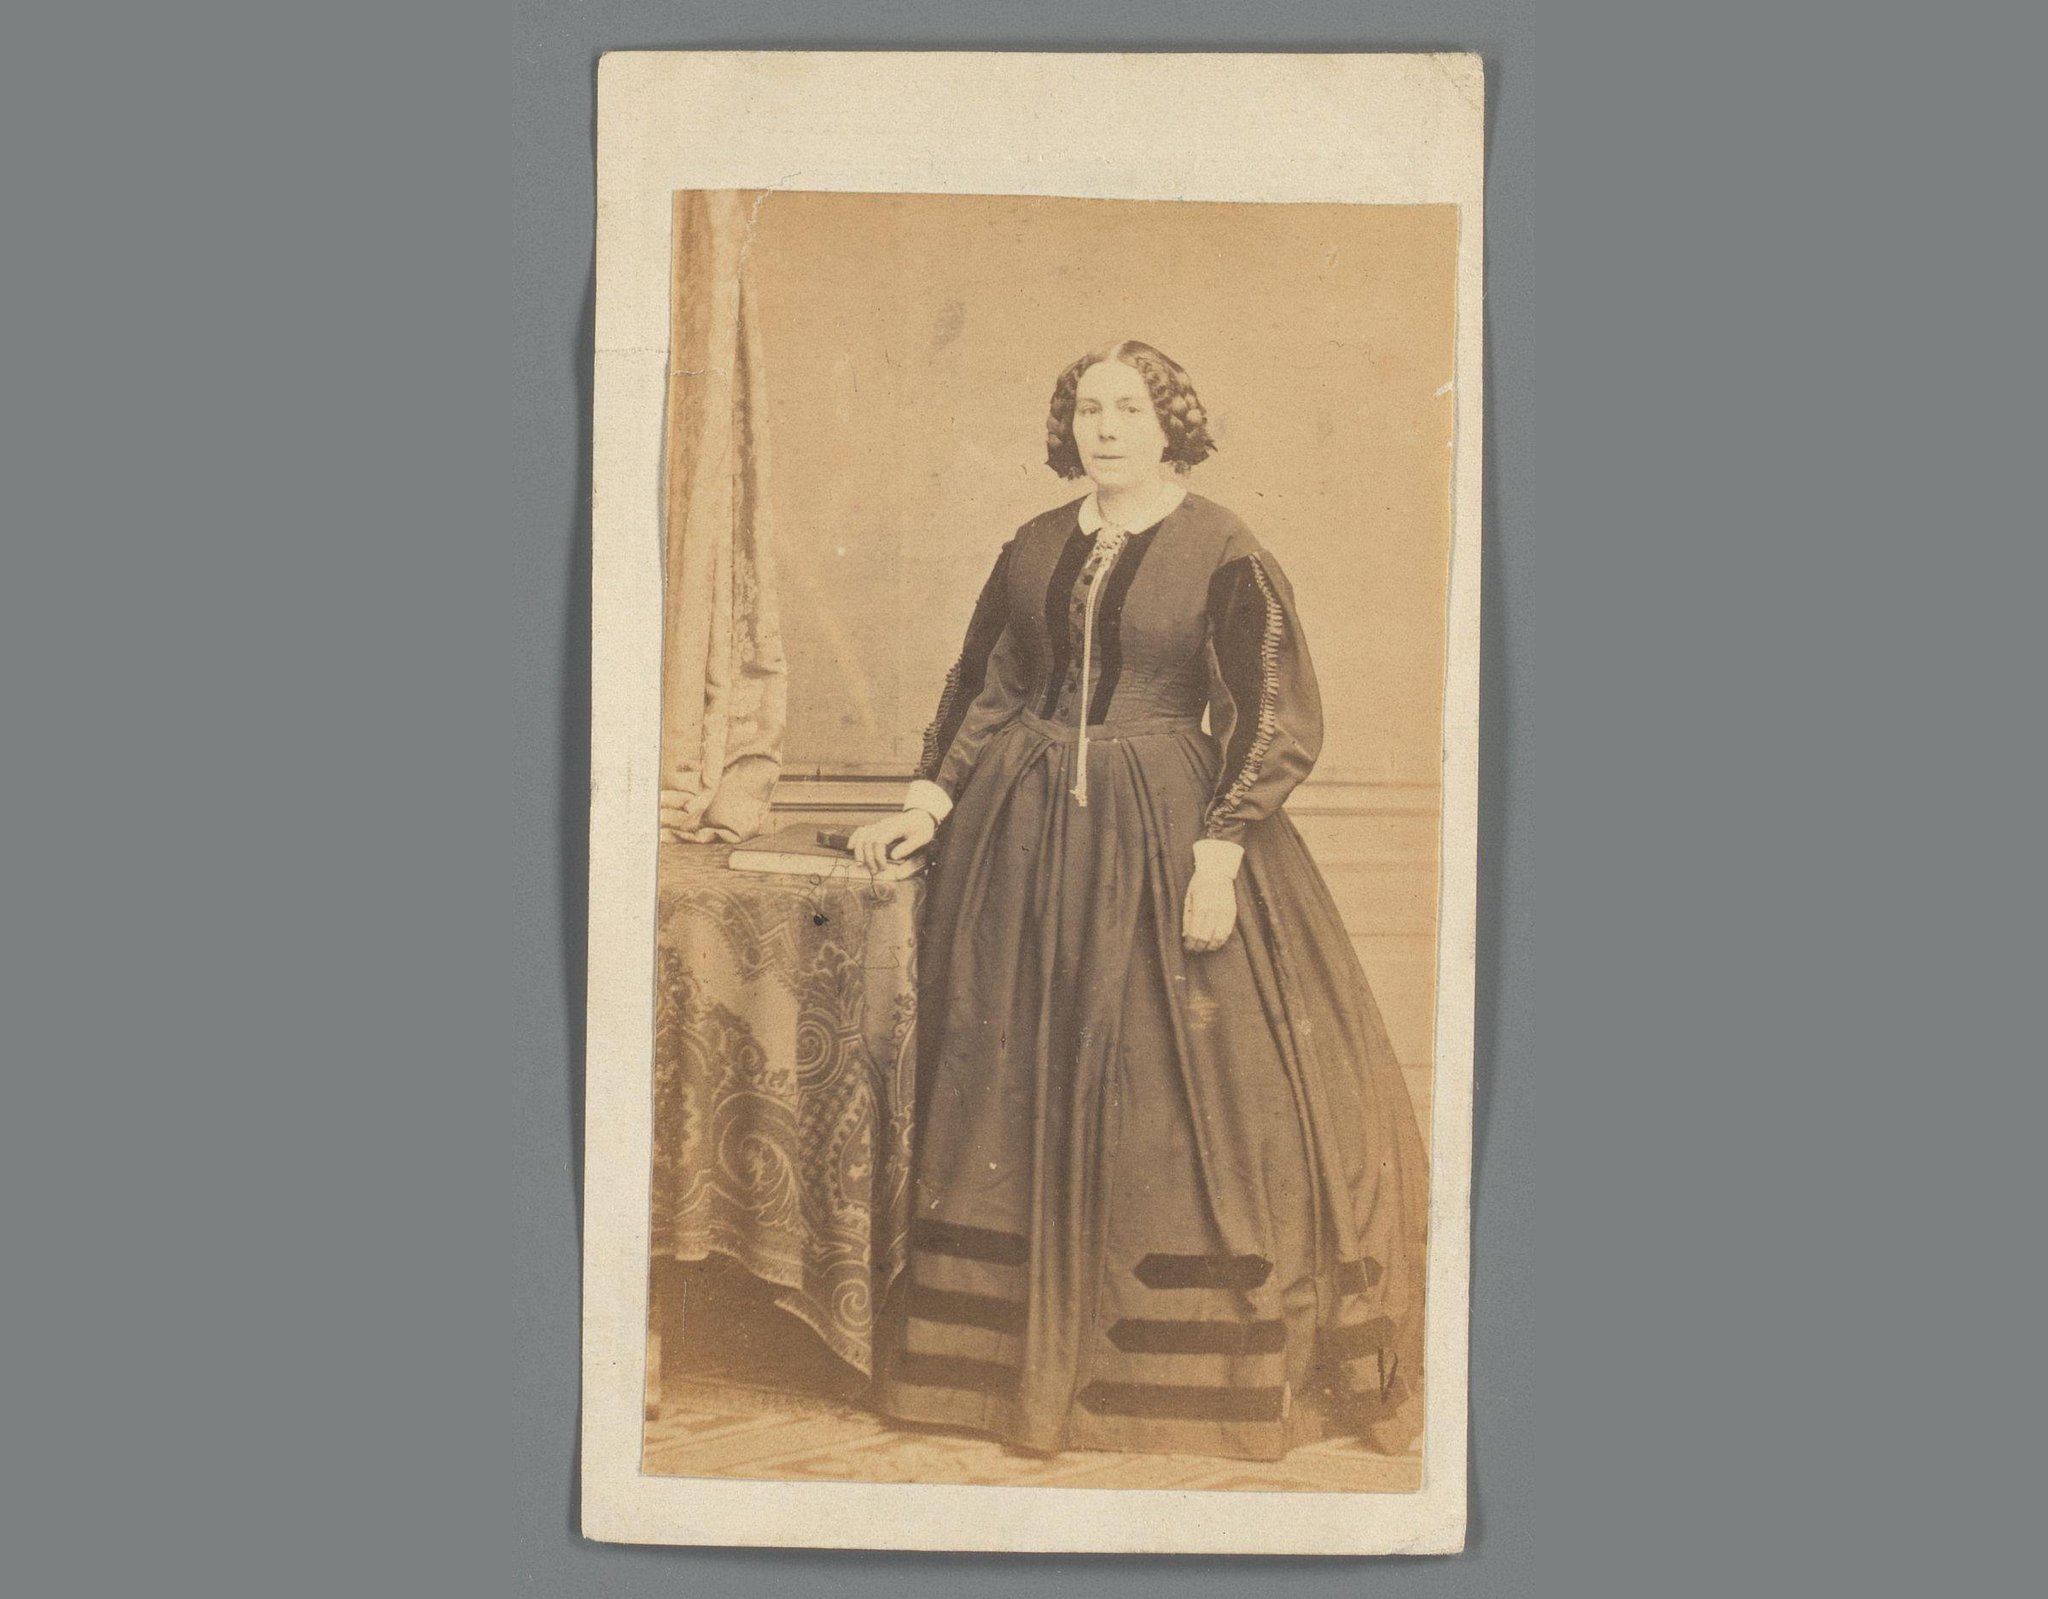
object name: prayer card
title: Portret van Jeanne de Maertelaere op bidprent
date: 1864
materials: paper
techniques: albumen print, letterpress printing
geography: antwerp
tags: adult woman, historical persons, antwerp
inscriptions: inscription: ‘Doux coeur de Marie, soyez mon refuge (...) St Jérome./ Anvers. Typ. C. De Backer, rue Zirk.’